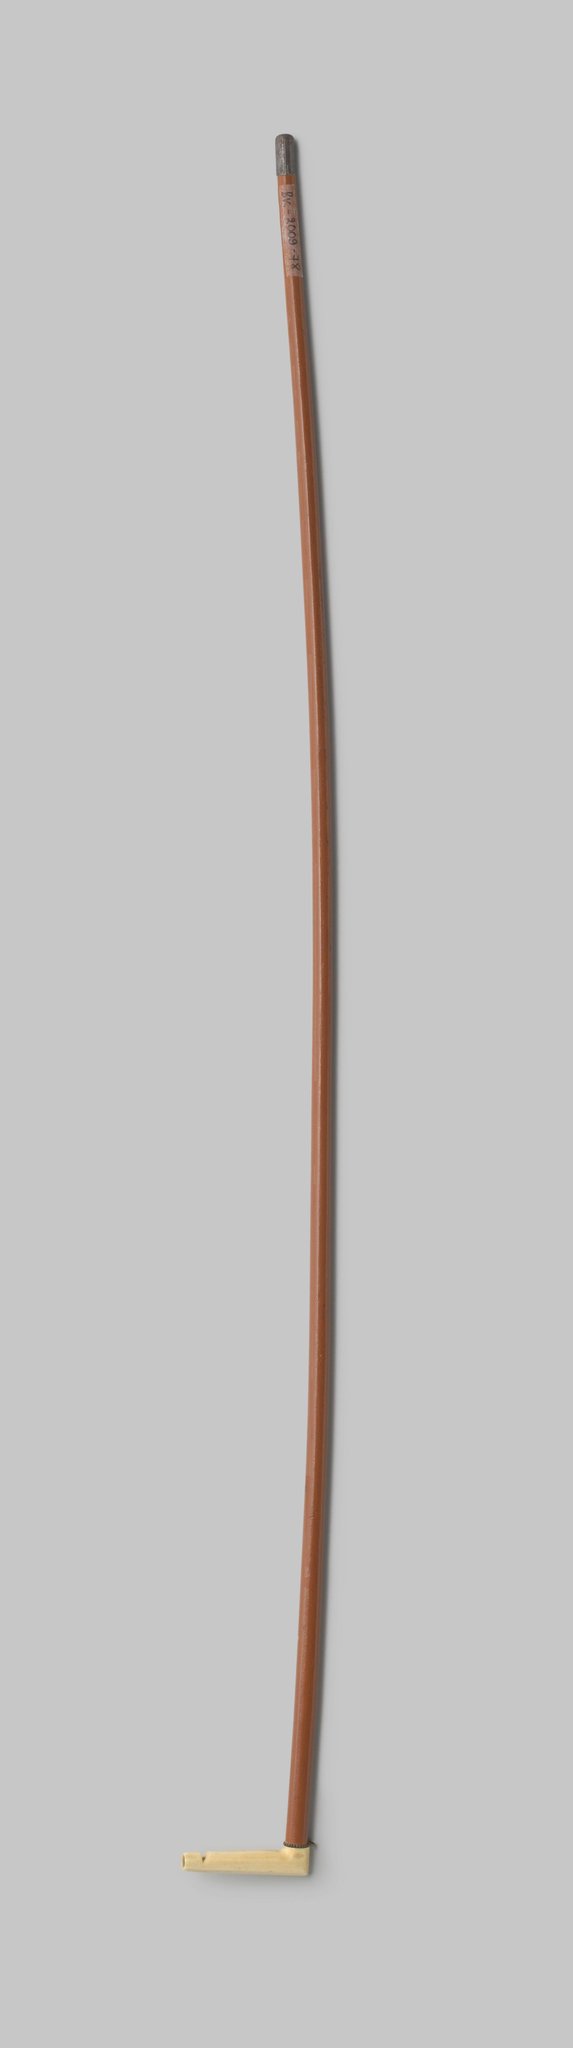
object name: onderstok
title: Onderstok van parasol of parapluie van hout met knop van been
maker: gustav schnitzler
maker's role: paraplufabrikant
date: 1920-1940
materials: bone, metal, wood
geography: nijmegen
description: Parapluie- of parasolonderstok van hout met knop van been.